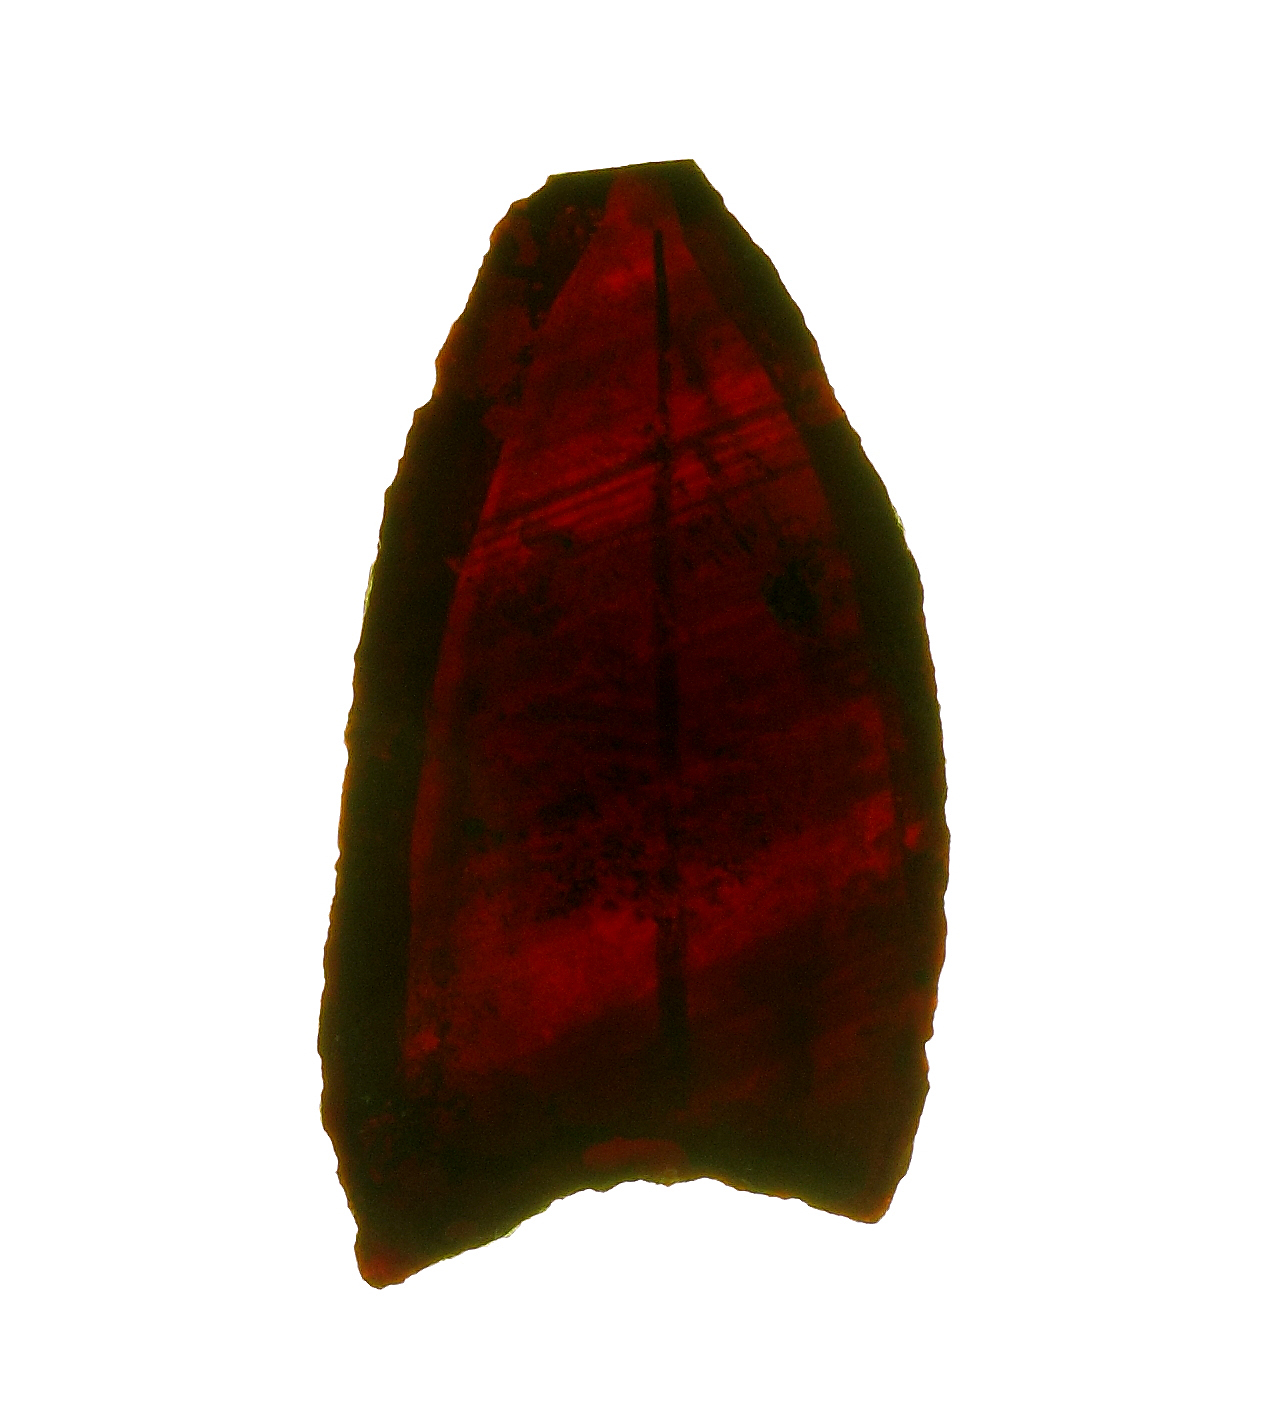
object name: fragment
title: Glass Fragments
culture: european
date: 1201-1400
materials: glass, metal